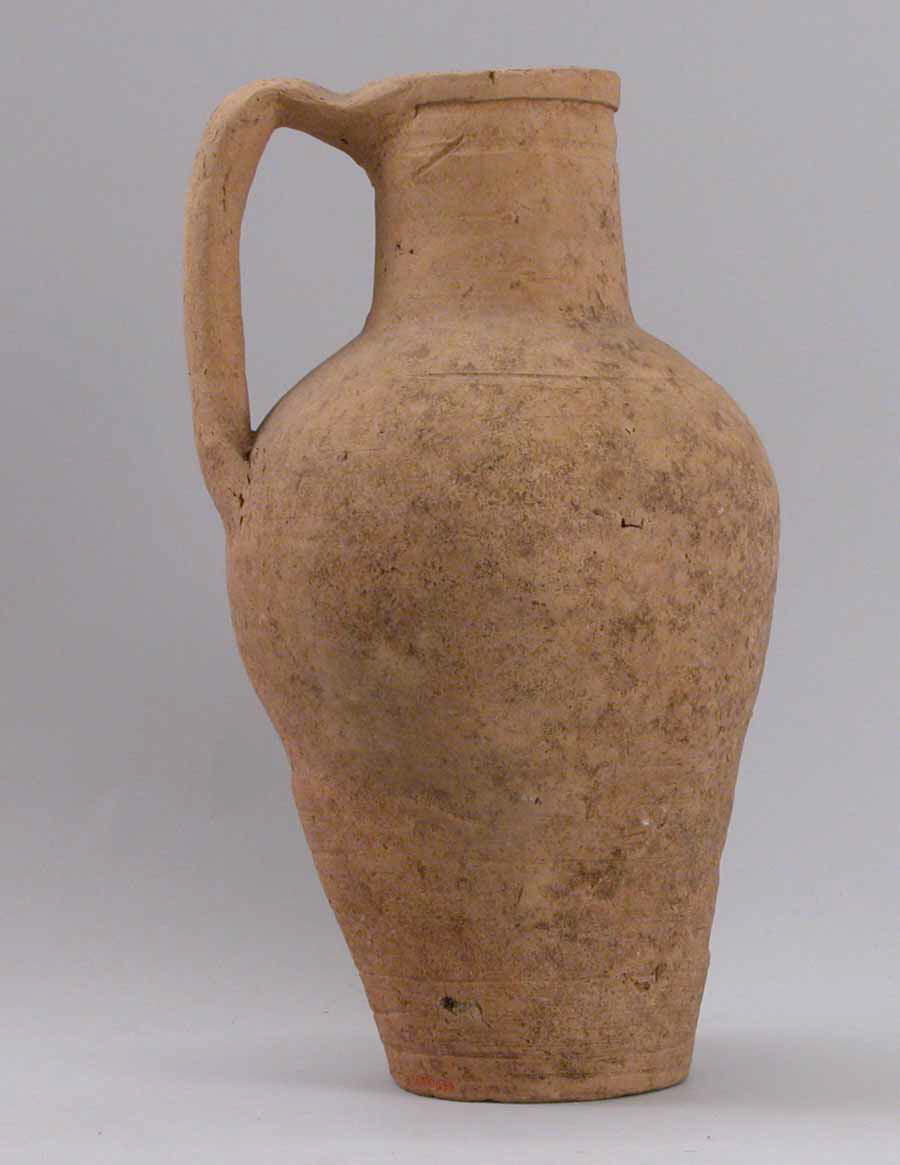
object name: jug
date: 801-900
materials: earthenware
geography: iran